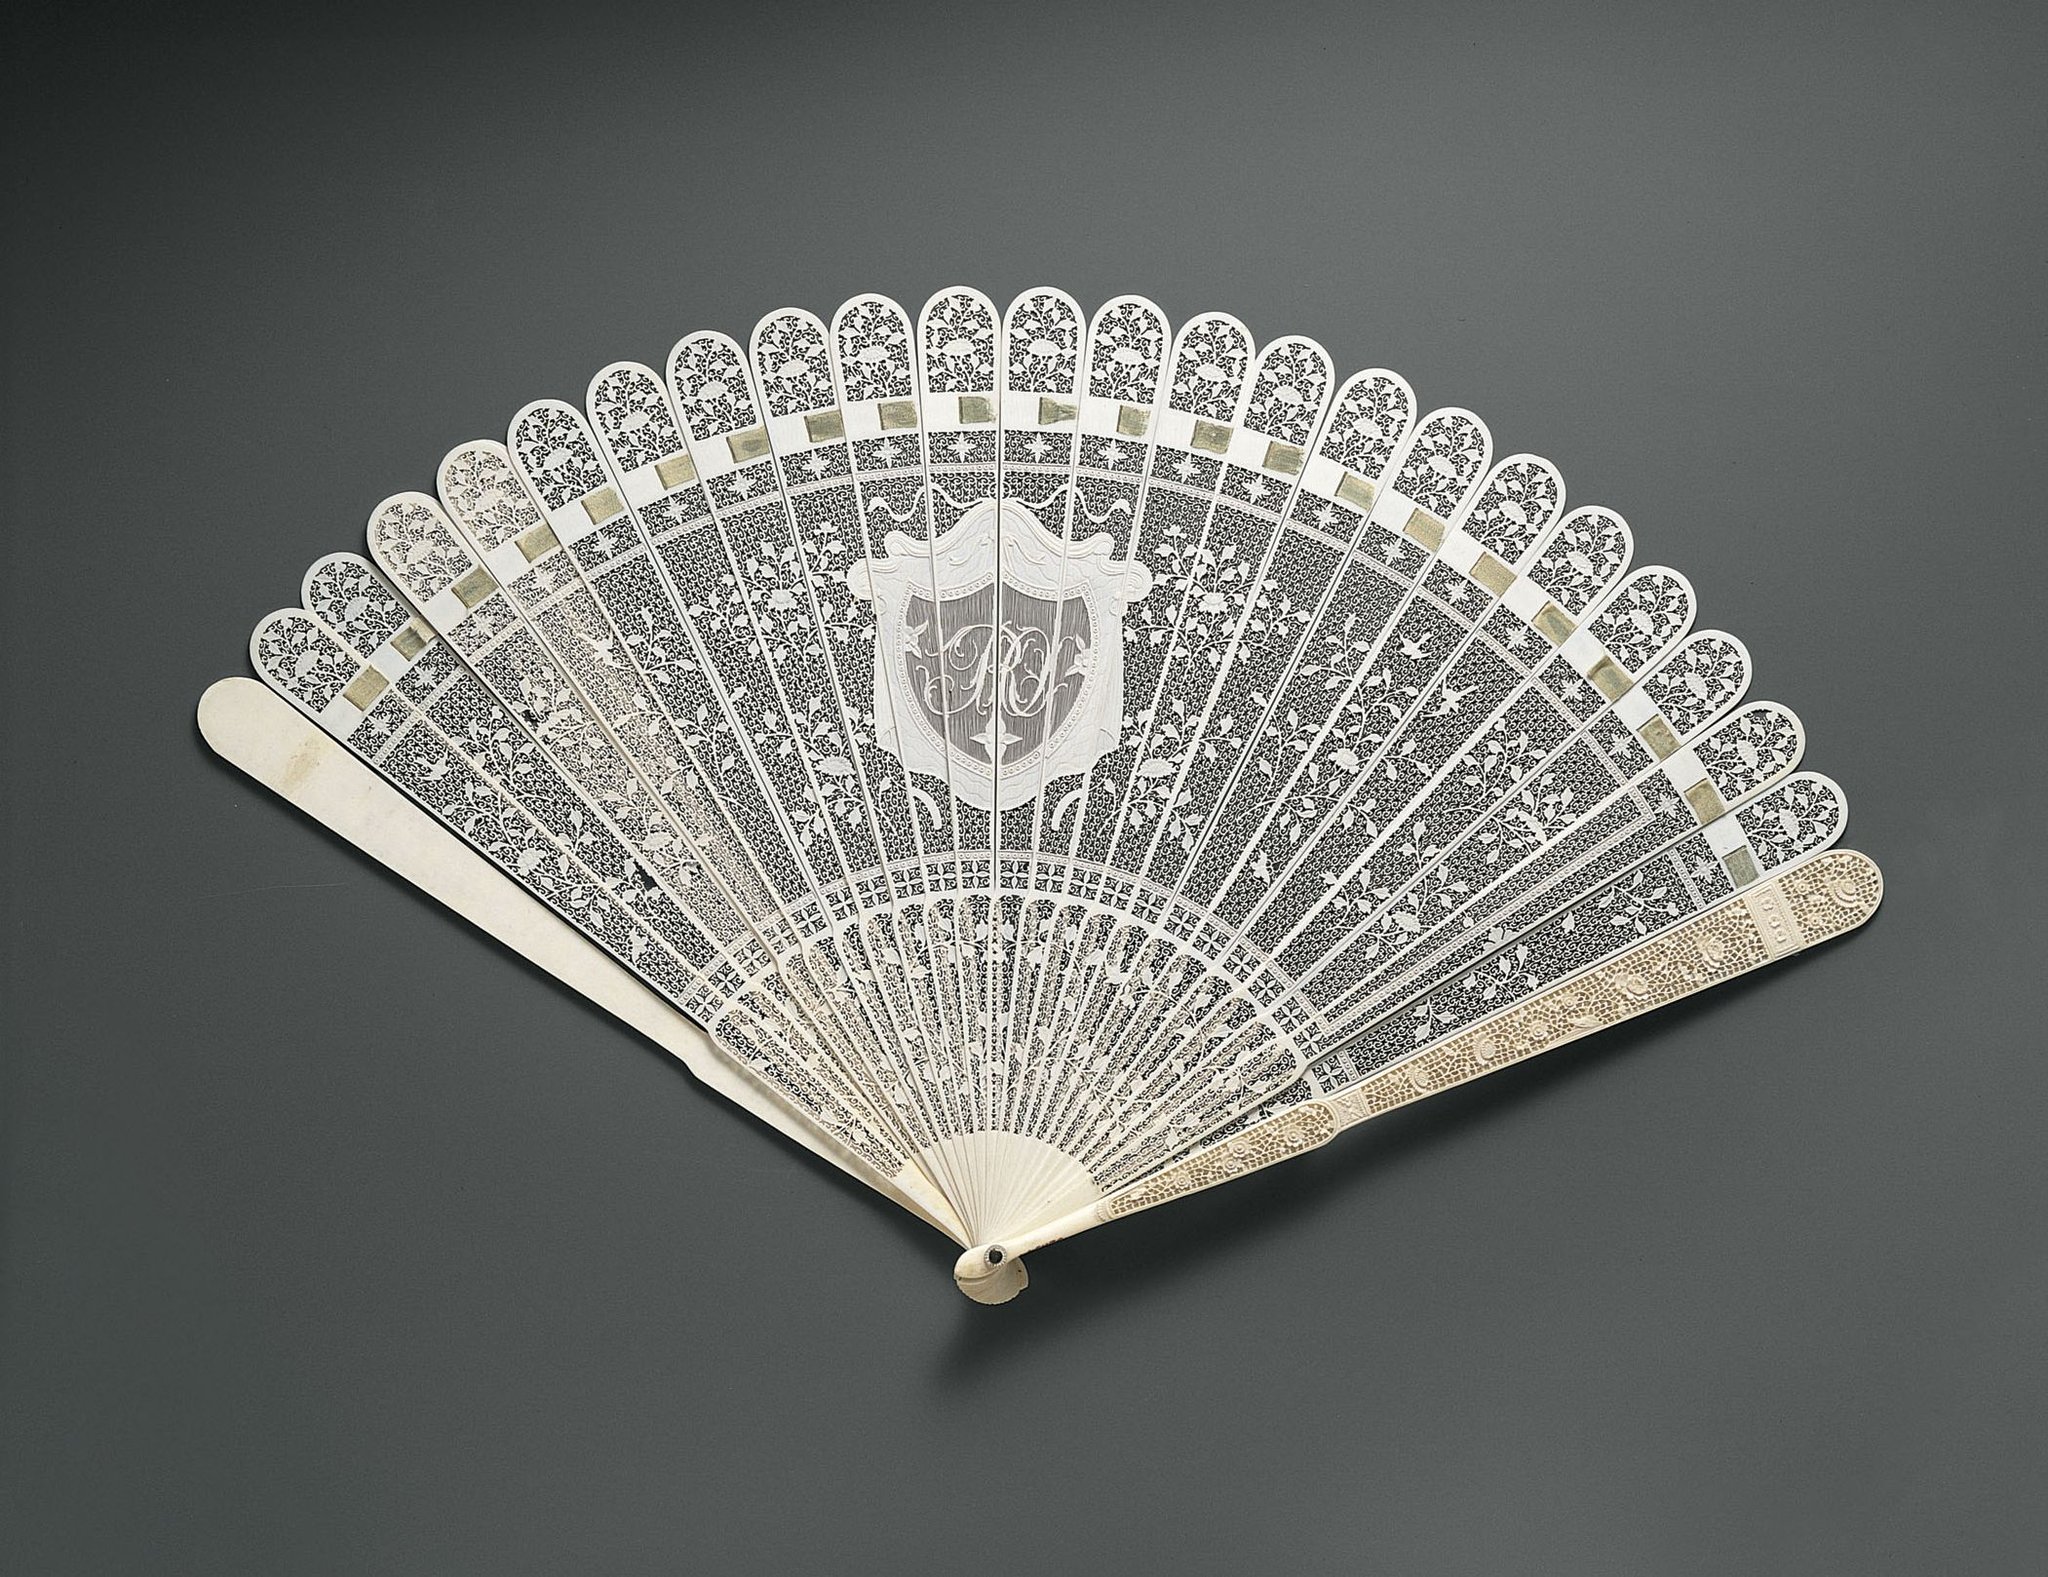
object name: fan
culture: chinese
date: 1800-1810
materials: ivory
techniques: carving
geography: china